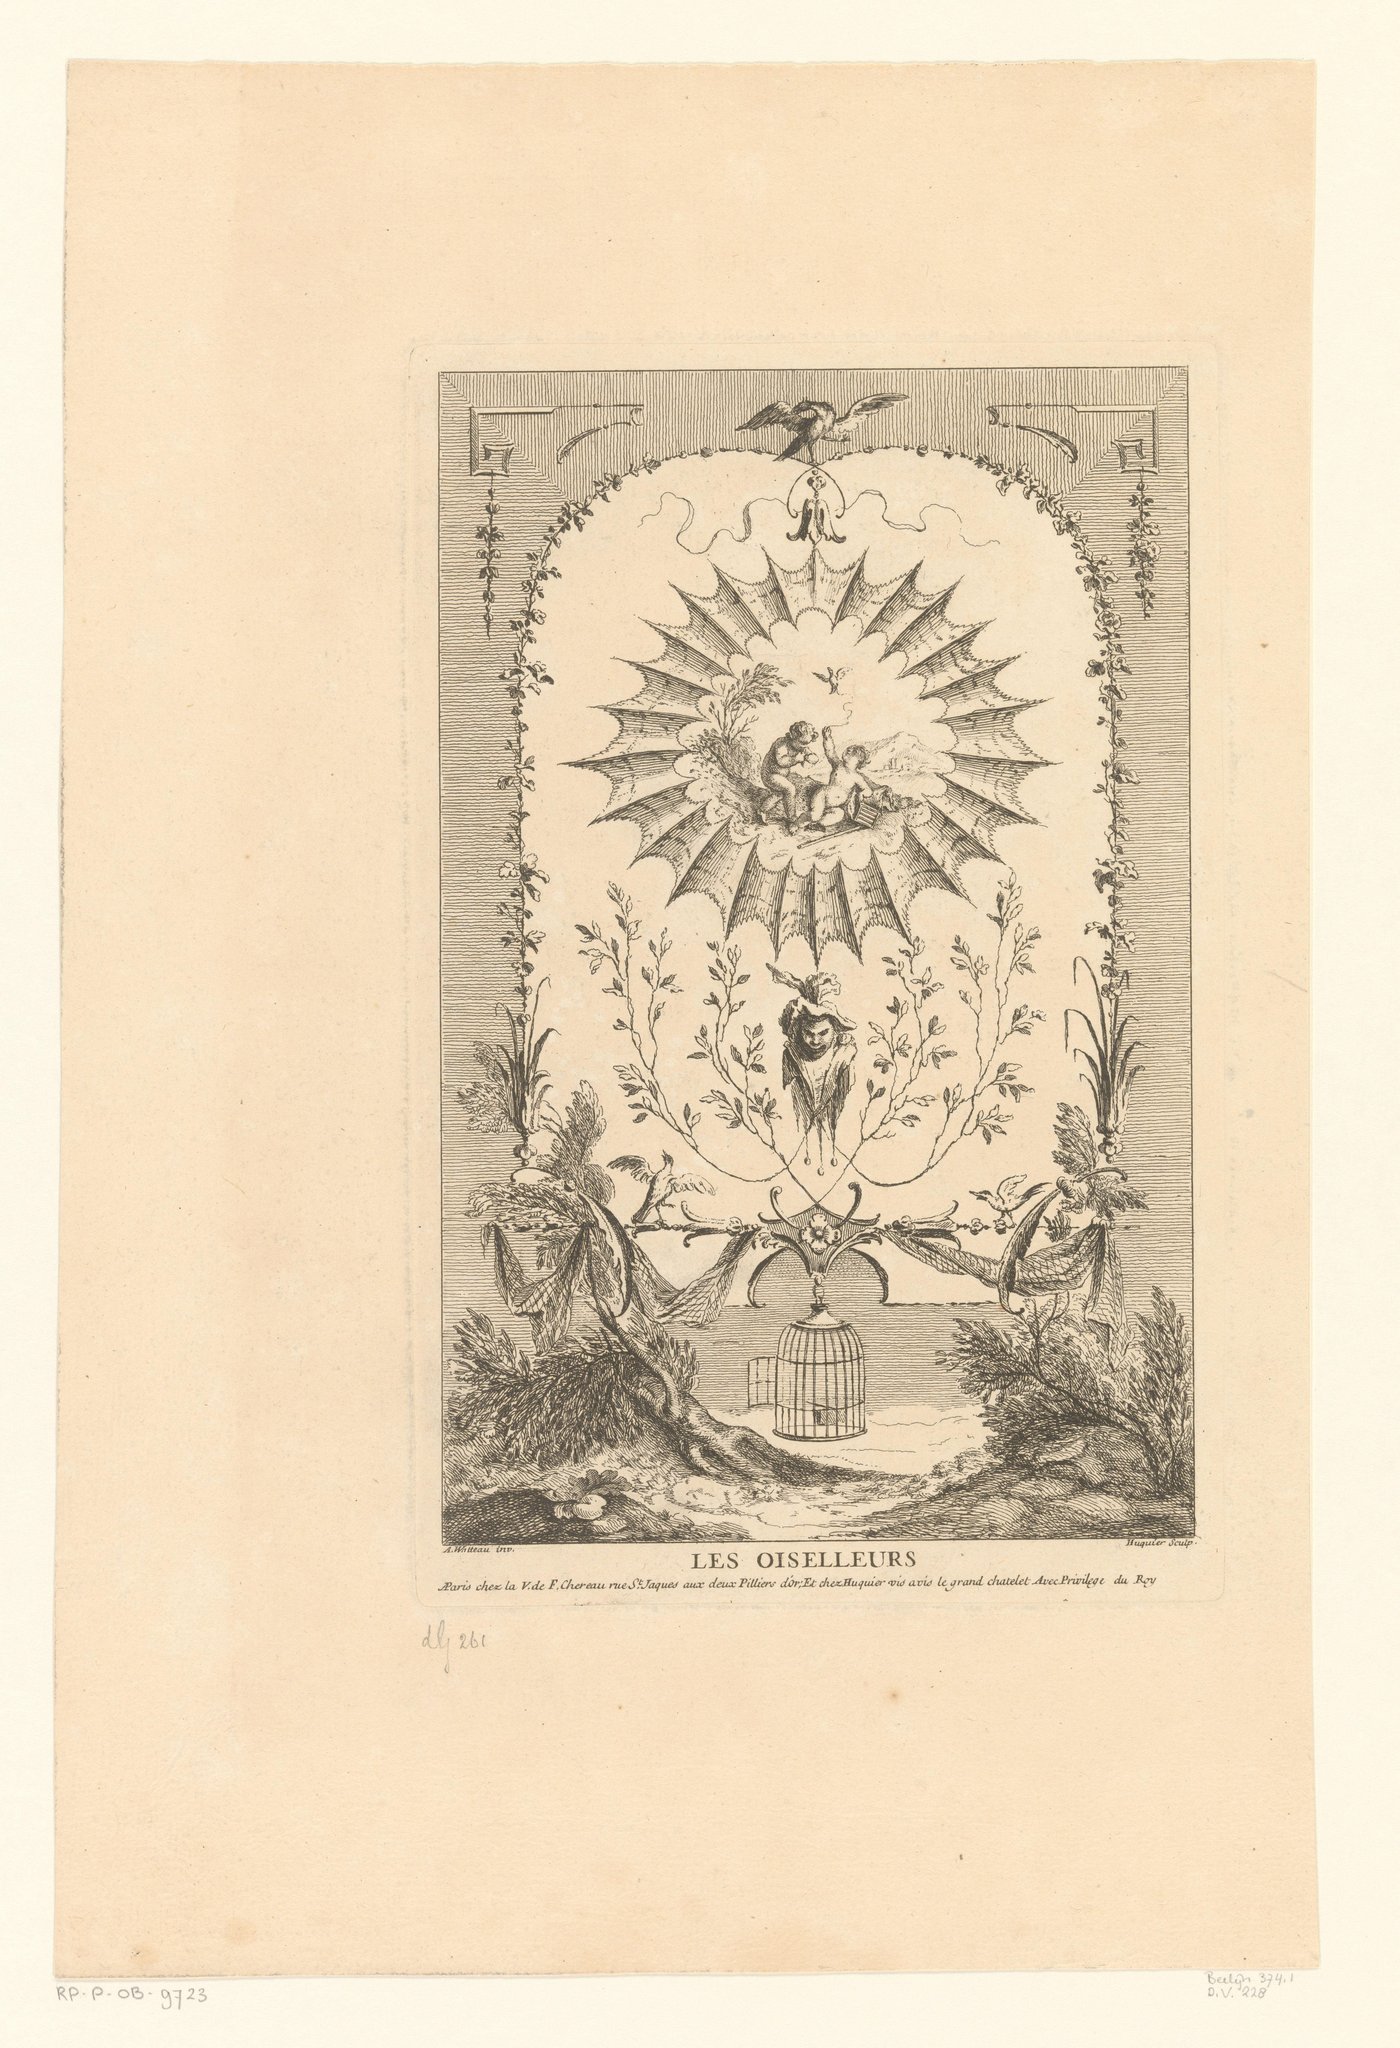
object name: ornament print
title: Vogelaars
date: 1729-1737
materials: paper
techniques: etching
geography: paris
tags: fowling, fowler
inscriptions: collector's mark: Lugt 2228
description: In een stervormige omlijsting zitten twee putti met een vogel en een kooi. Rondom een ornamentele omlijsting met bladmotieven, netten en vogels. Aan de onderzijde een landschap met een lege vogelkooi.